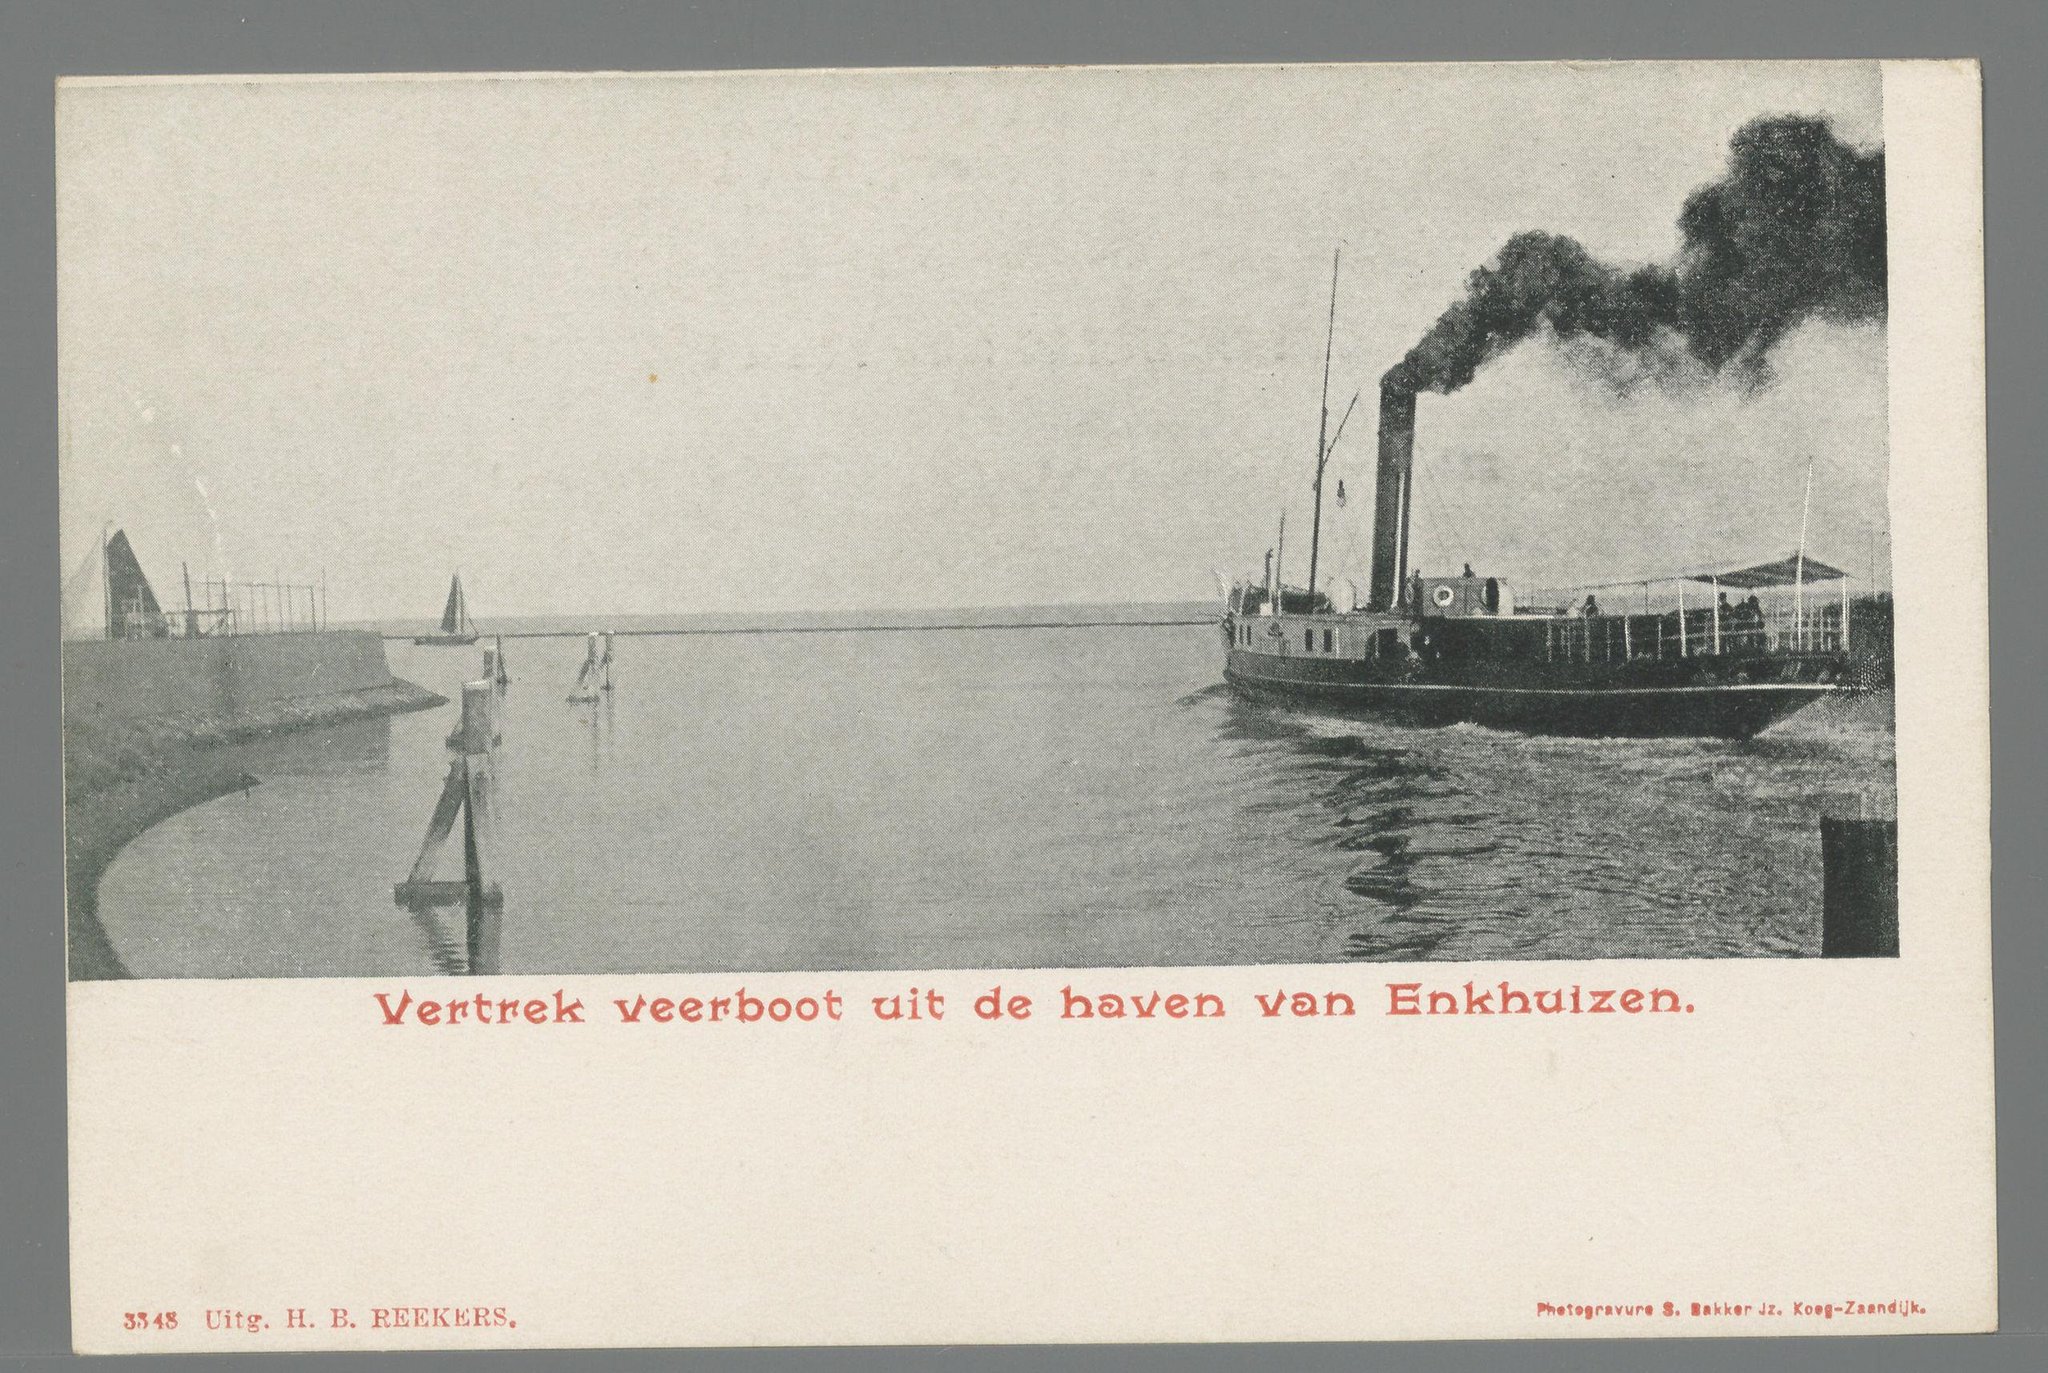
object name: ansichtkaart, prentbriefkaart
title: Vertrek veerboot uit de haven van Enkhuizen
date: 1899-1905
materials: cardboard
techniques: autotype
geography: koog aan de zaan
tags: harbour, ferry, steamship, motorship, enkhuizen